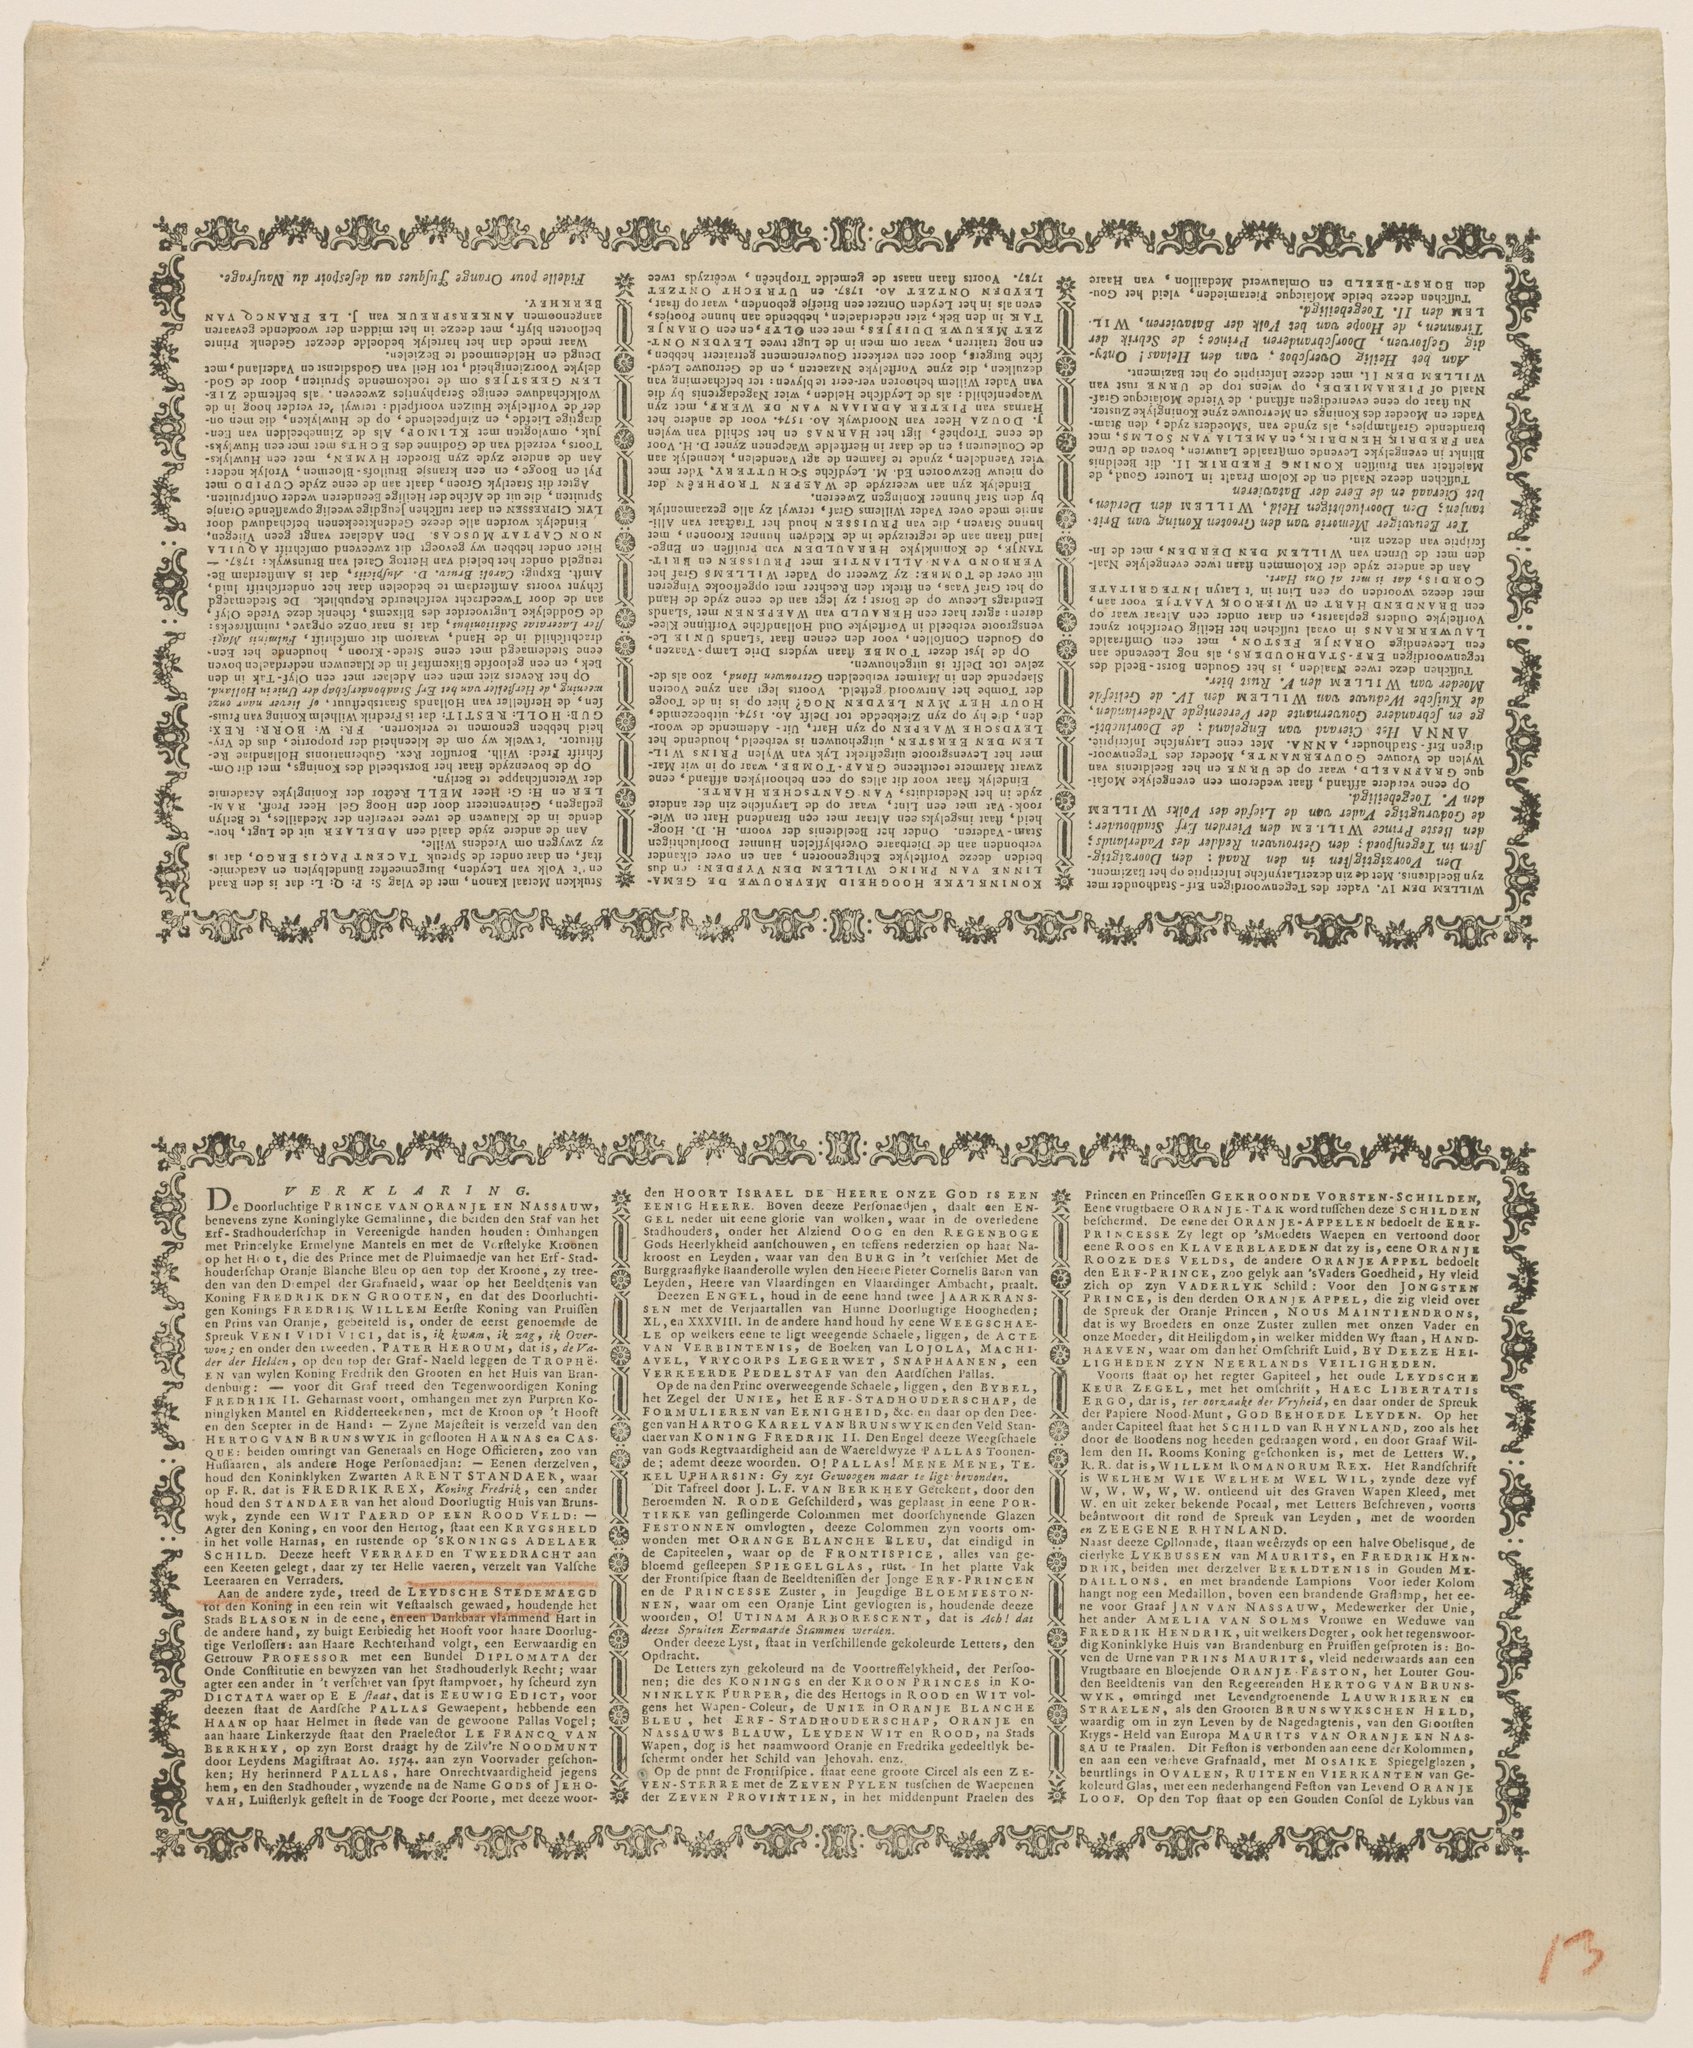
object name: text sheet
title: Verklaring bij de allegorie ter ere van de koning van Pruisen voor zijn herstel van het stadhouderschap van Willem V, 1788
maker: johannes le francq van berkhey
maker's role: draughtsman, print maker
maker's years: 1729-1812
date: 1789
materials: paper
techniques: engraving, etching, letterpress printing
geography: netherlands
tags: william v (prince of orange)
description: Tekstblad met een verklaring van de allegorie ter ere van de koning van Pruisen voor zijn herstel van het stadhouderschap van Willem V, 1788. Verklaring in het Nederlands in twee delen van drie kolommen elk gedrukt op één blad (zonder de lege cartouche).